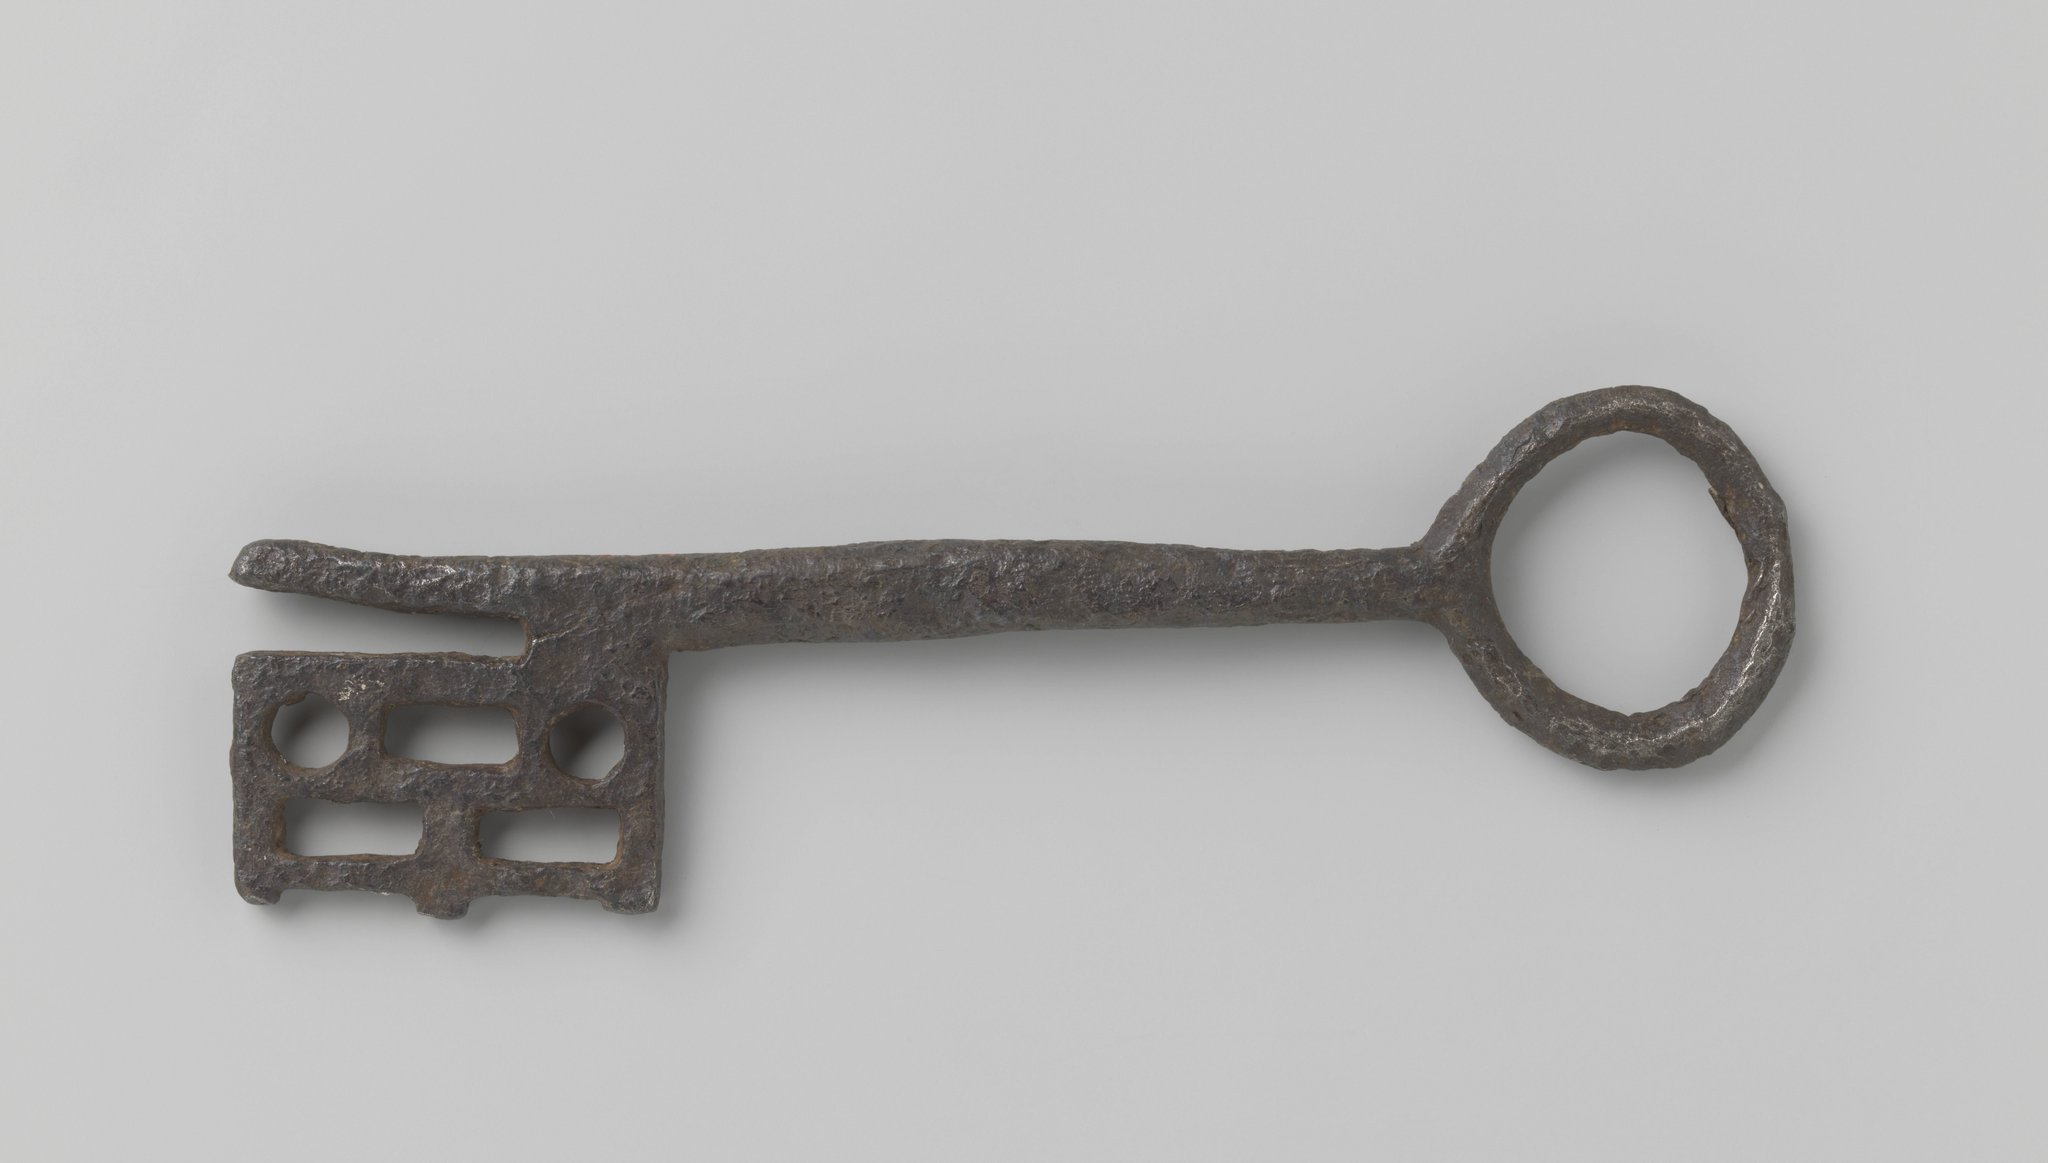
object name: key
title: Sleutel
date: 1300-1400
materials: iron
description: Sleutel met vierzijdige schacht, ringvormig oog en opengewerkte vierhoekige baard met drie langwerpige en twee ronde uitsnijdingen.